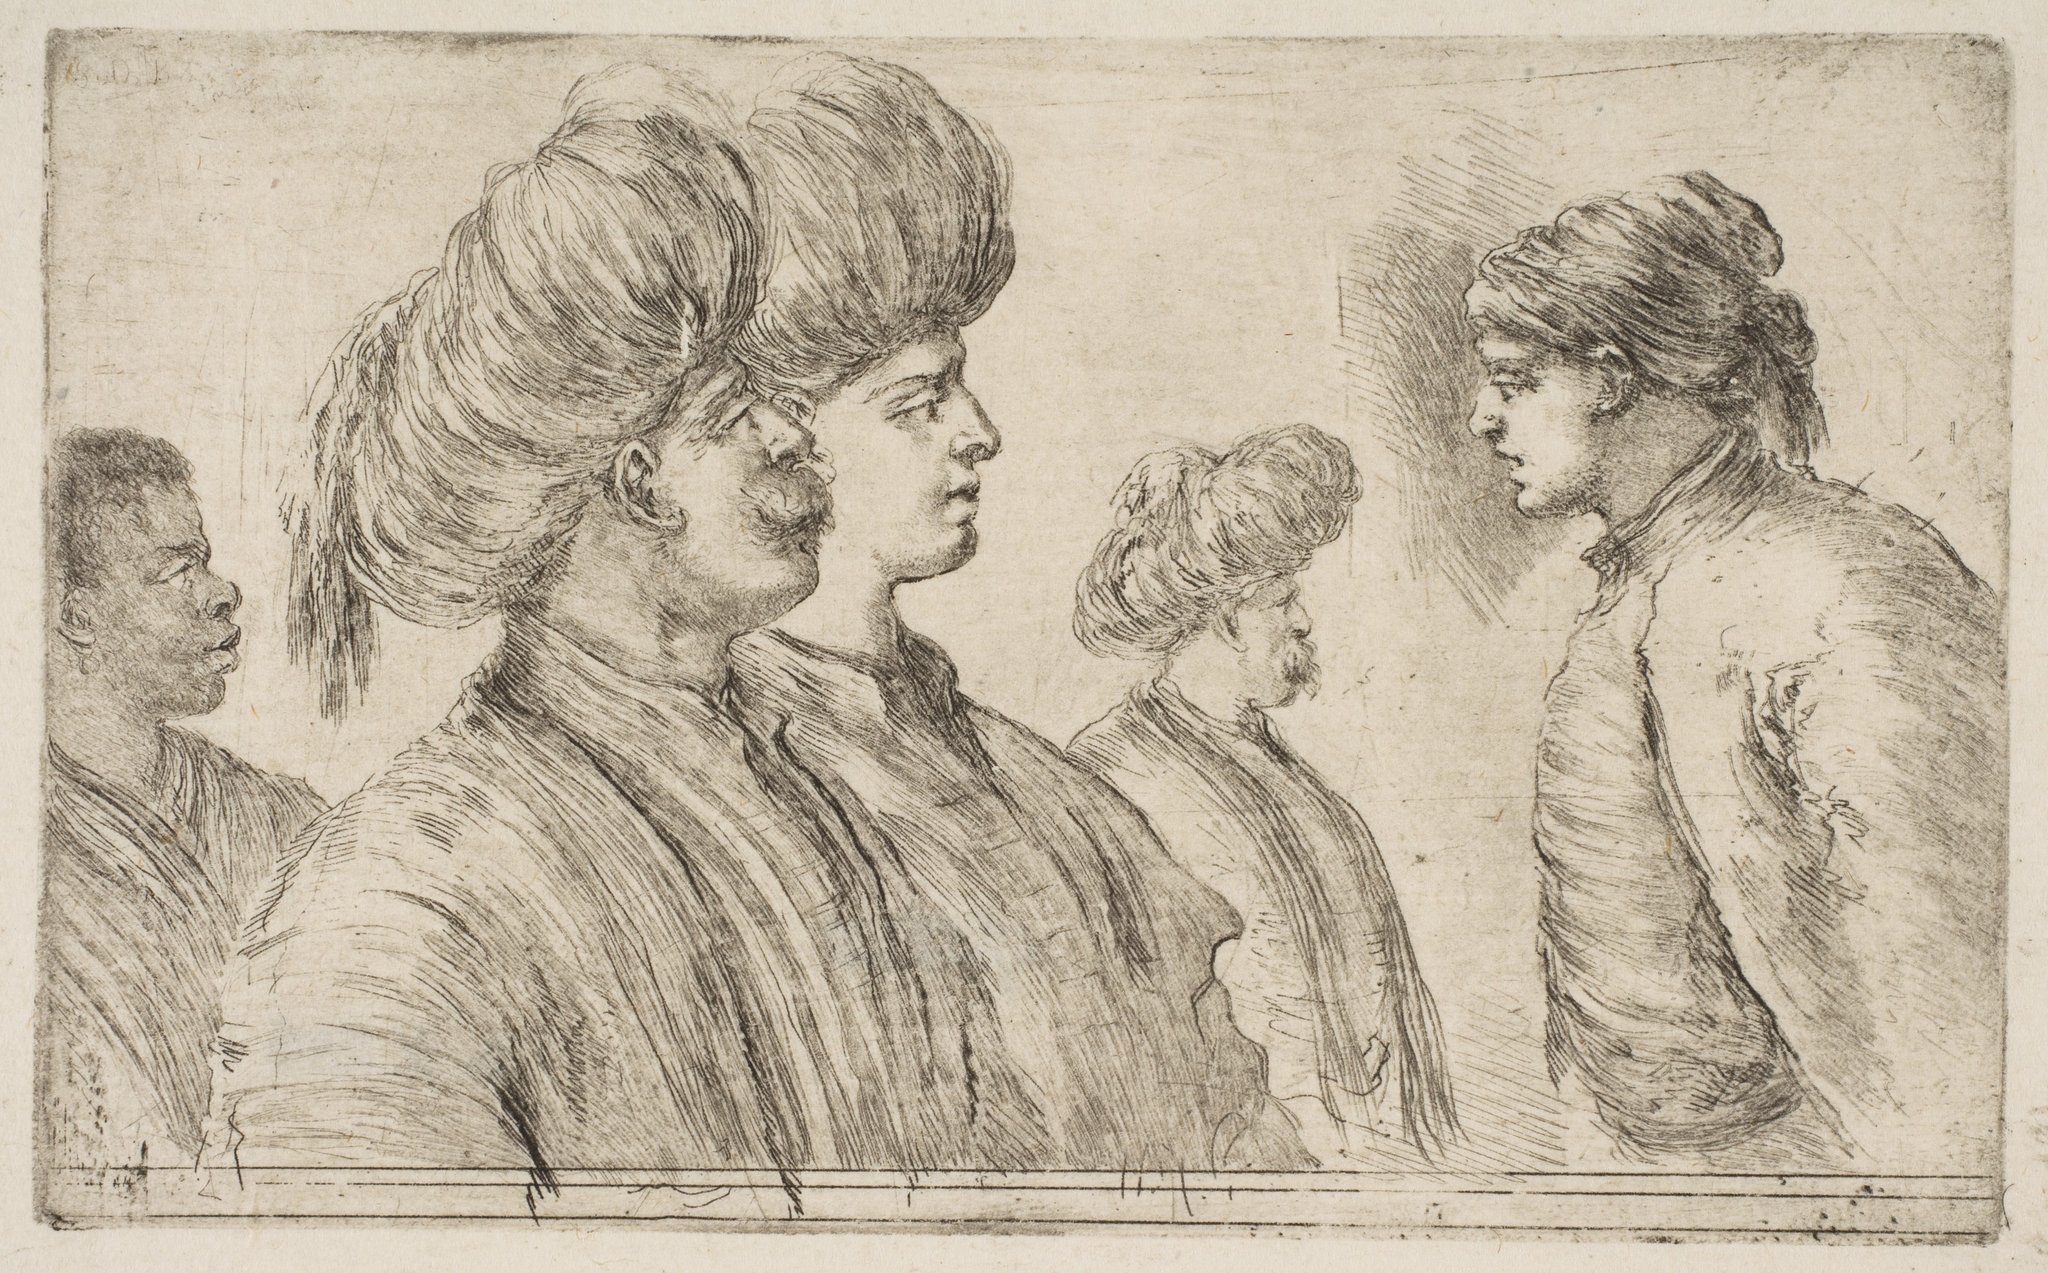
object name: print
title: Four Turks and a Black Man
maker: stefano della bella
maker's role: artist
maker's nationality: italian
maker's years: 1610-1664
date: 1662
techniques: etching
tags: men